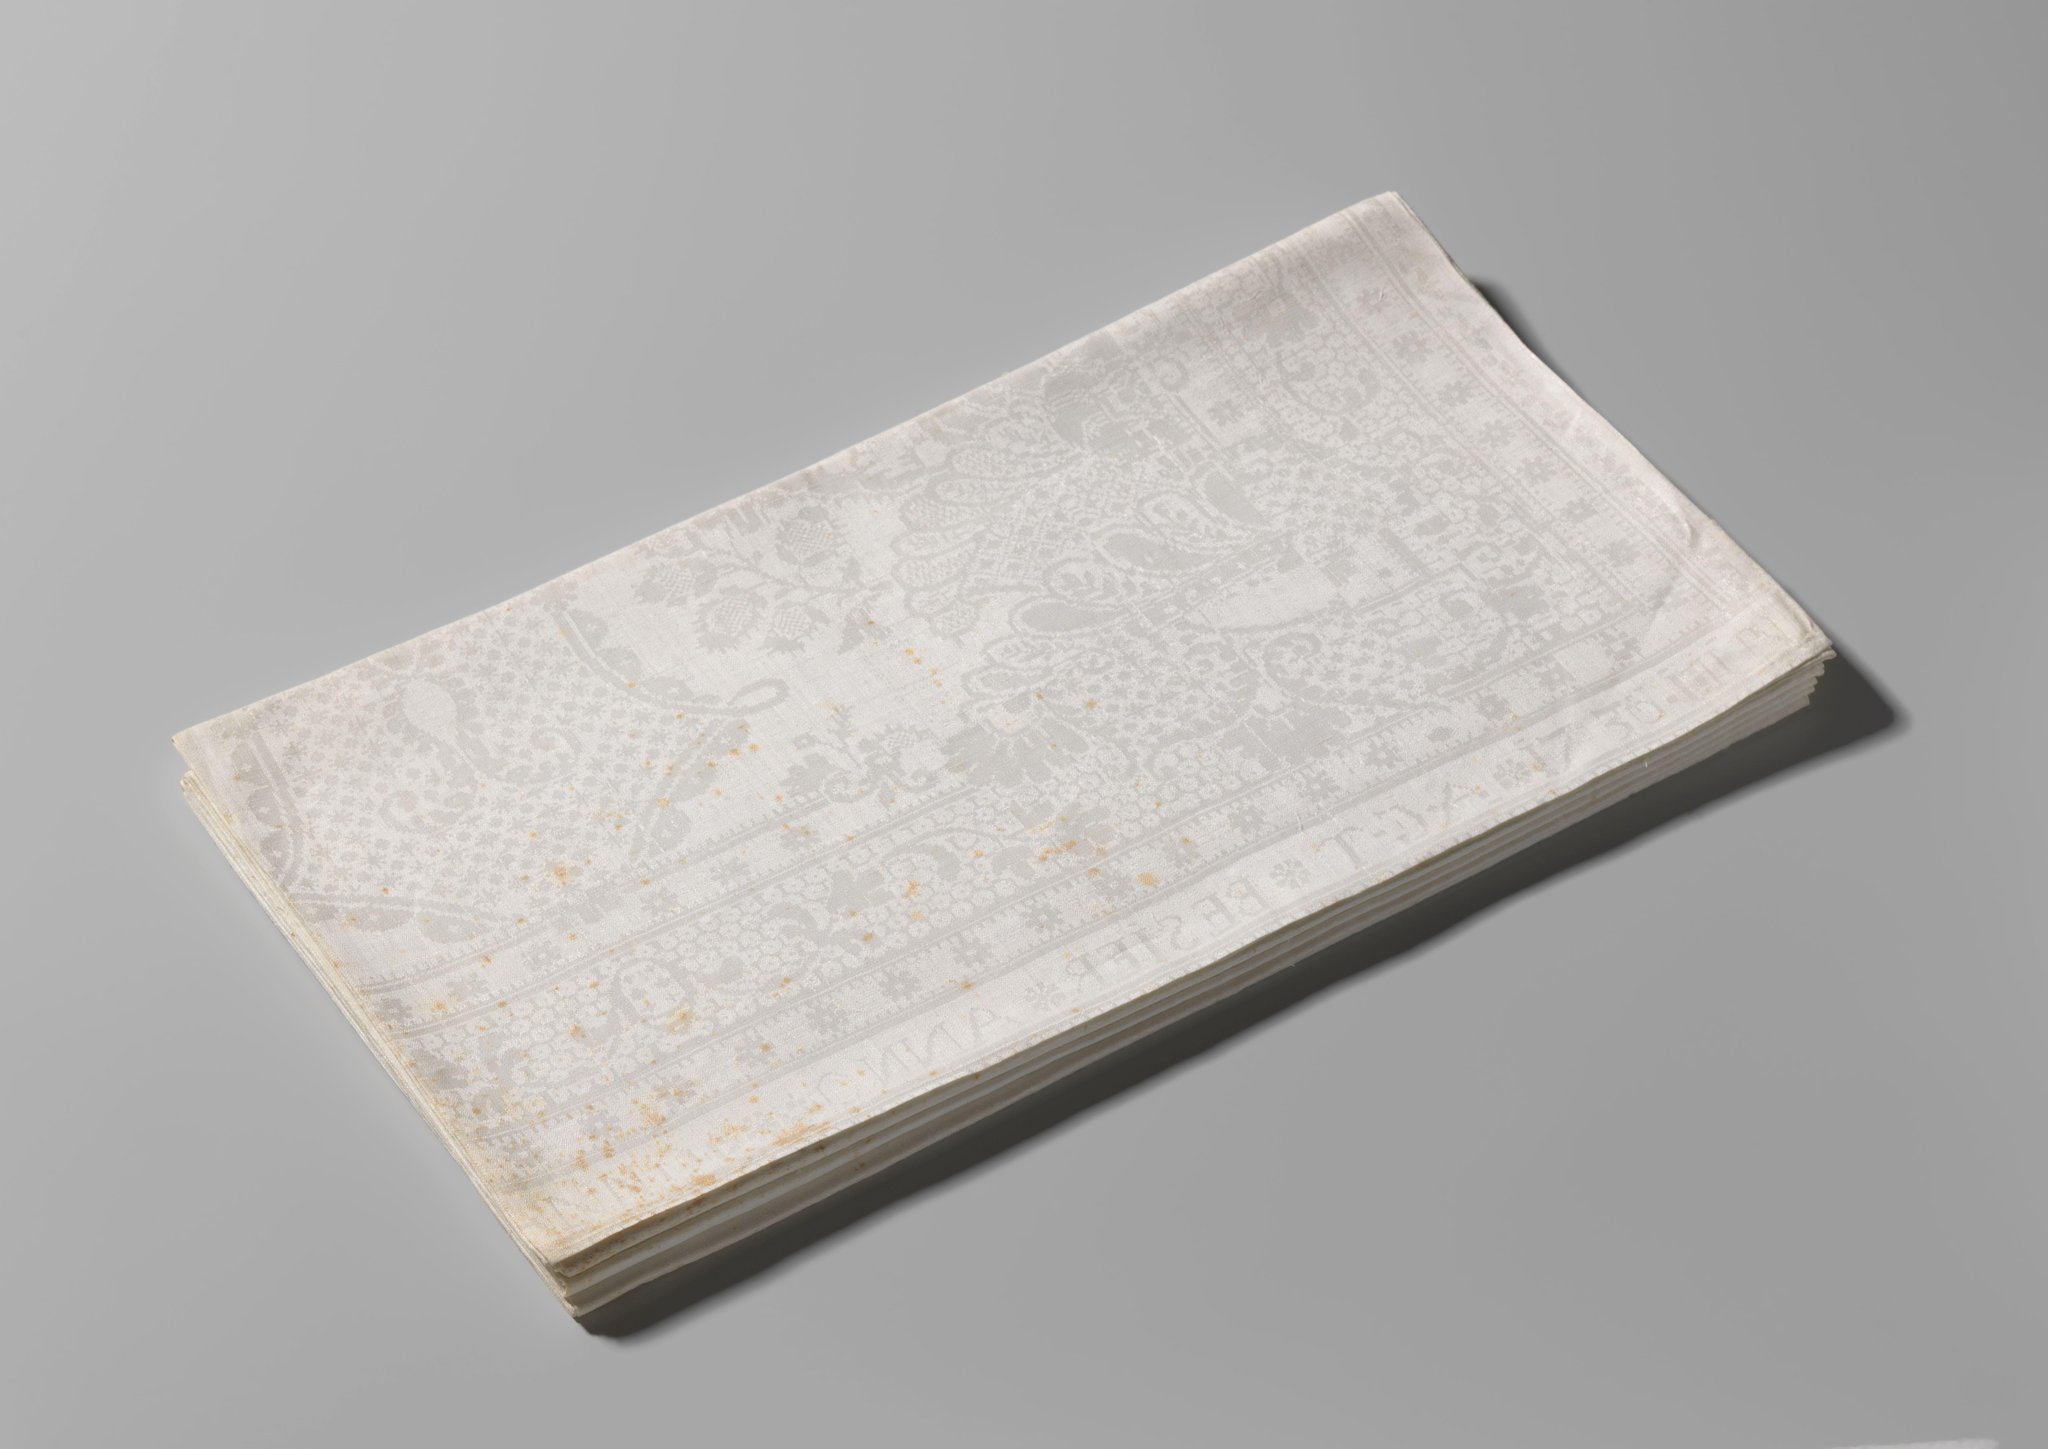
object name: tablecloth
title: Tafellaken van wit linnendamast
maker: Anonymous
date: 1736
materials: linen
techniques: damask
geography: southern netherlands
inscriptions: date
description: Wit linnen damasten tafellaken, versierd met "kant"-patroon en ingeweven AGT BESIER ANNO 1736 en GHD IORDENS ANNO 1736.